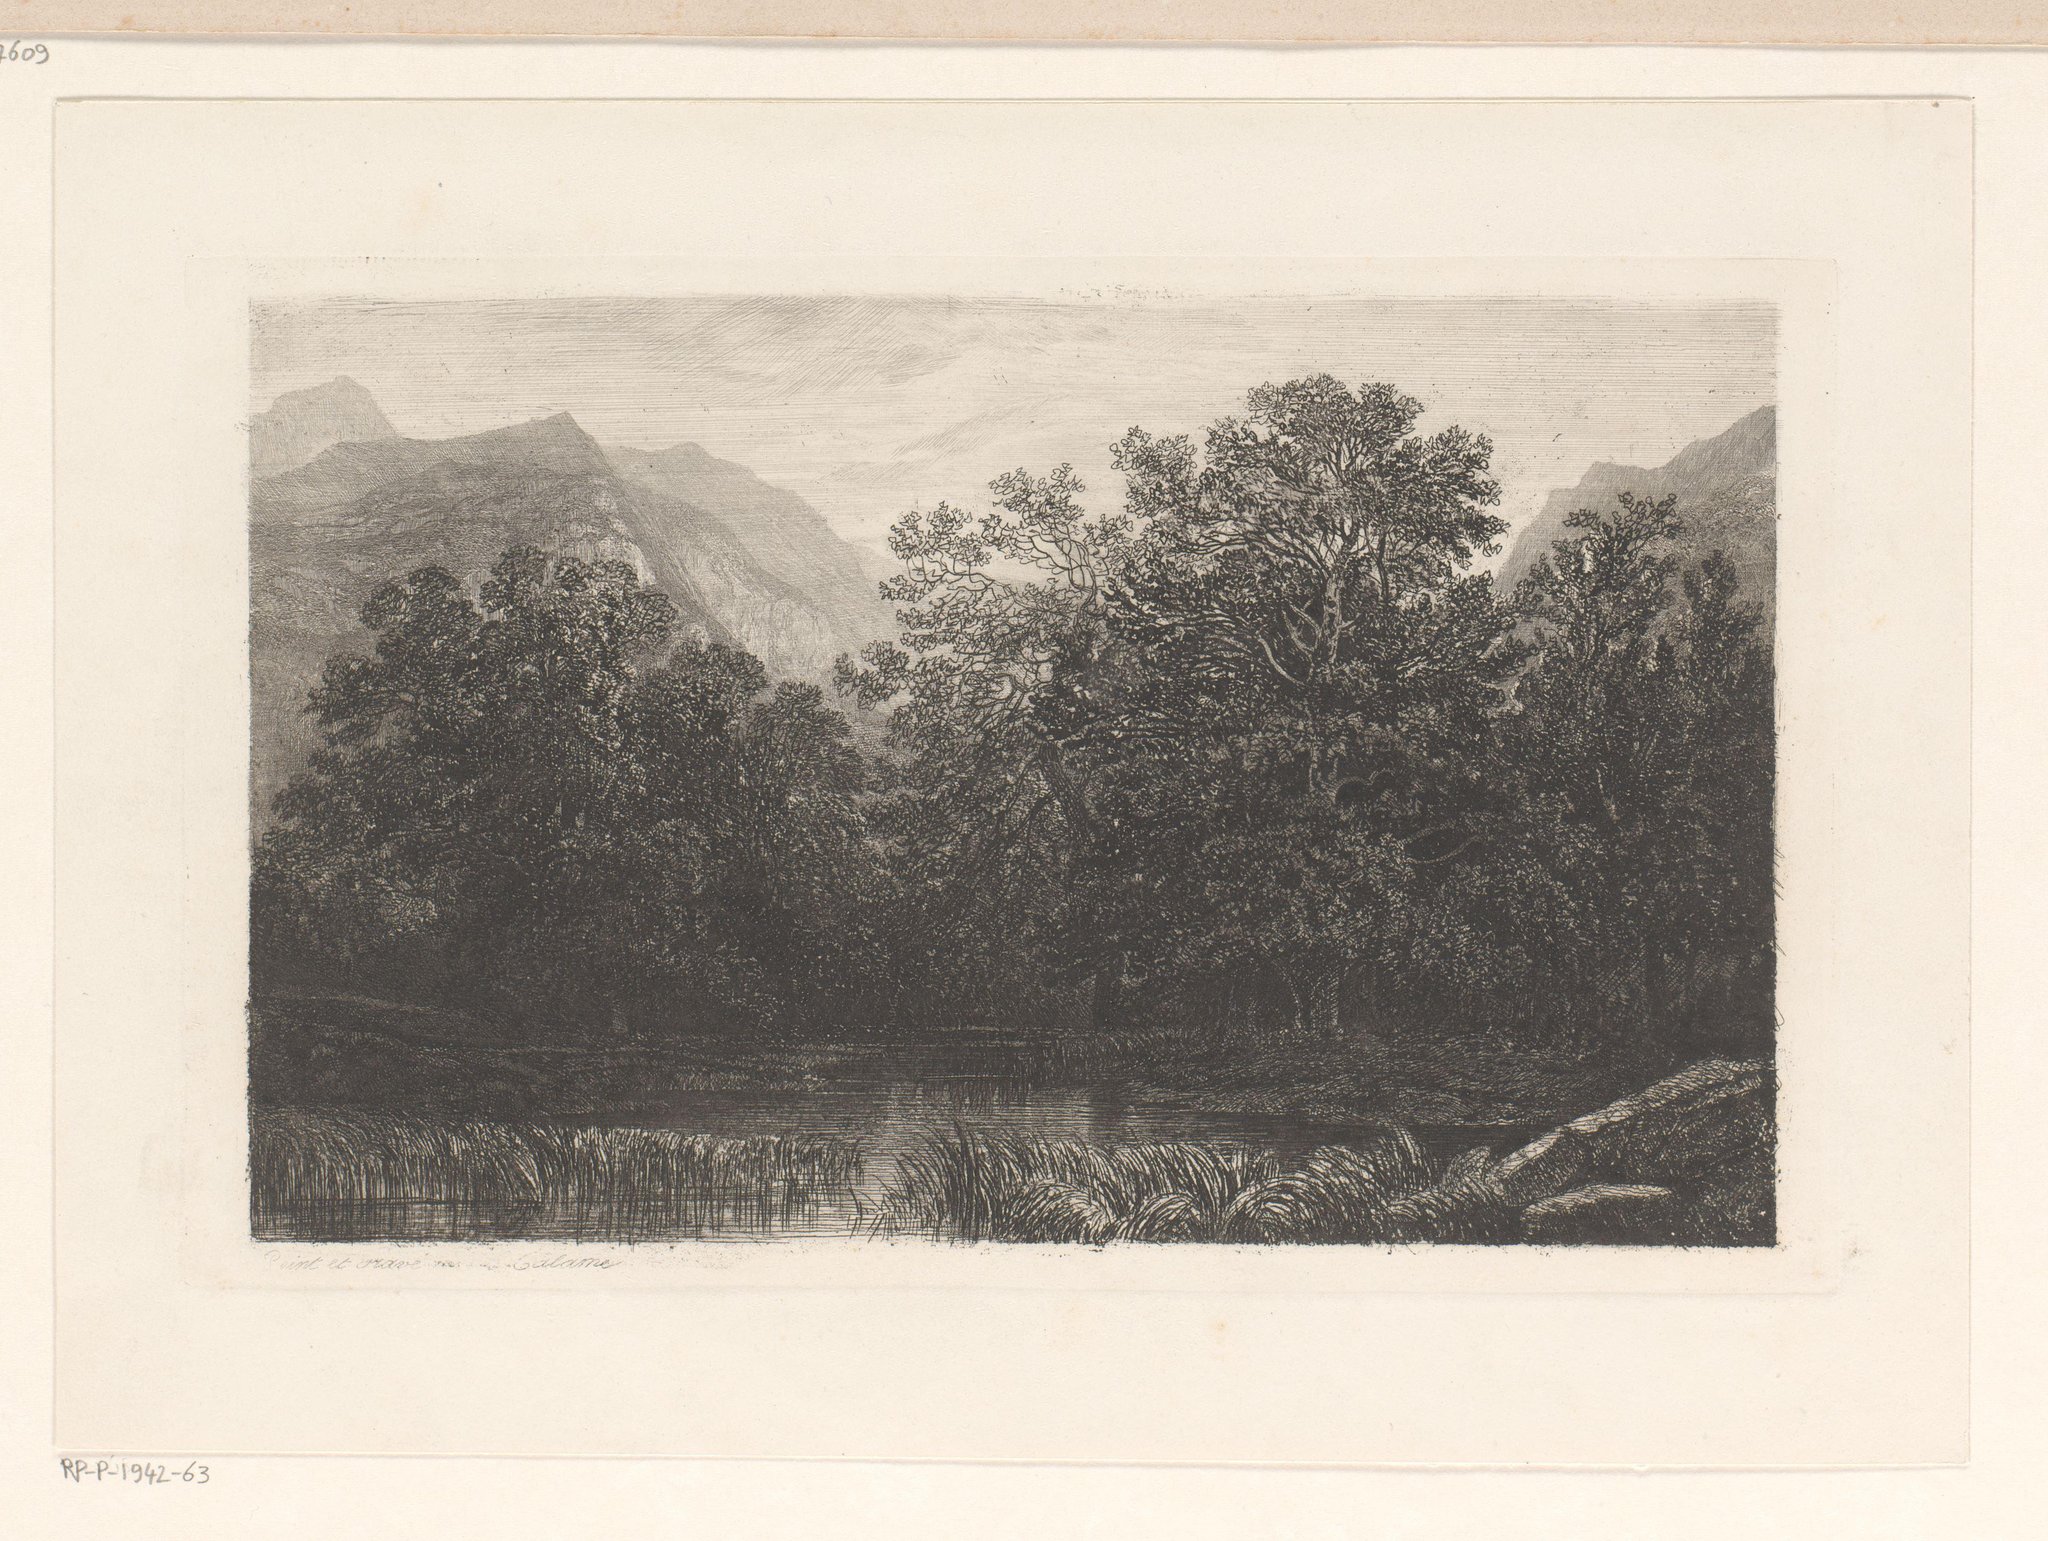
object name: print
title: Essais de gravure a l'eau forte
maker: alexandre calame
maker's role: draughtsman, painter, print maker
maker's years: 1810-1864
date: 1820-1864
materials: paper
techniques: etching, roulette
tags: deciduous forest, mountains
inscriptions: collector's mark: 2760, collector's mark: Lugt 2228